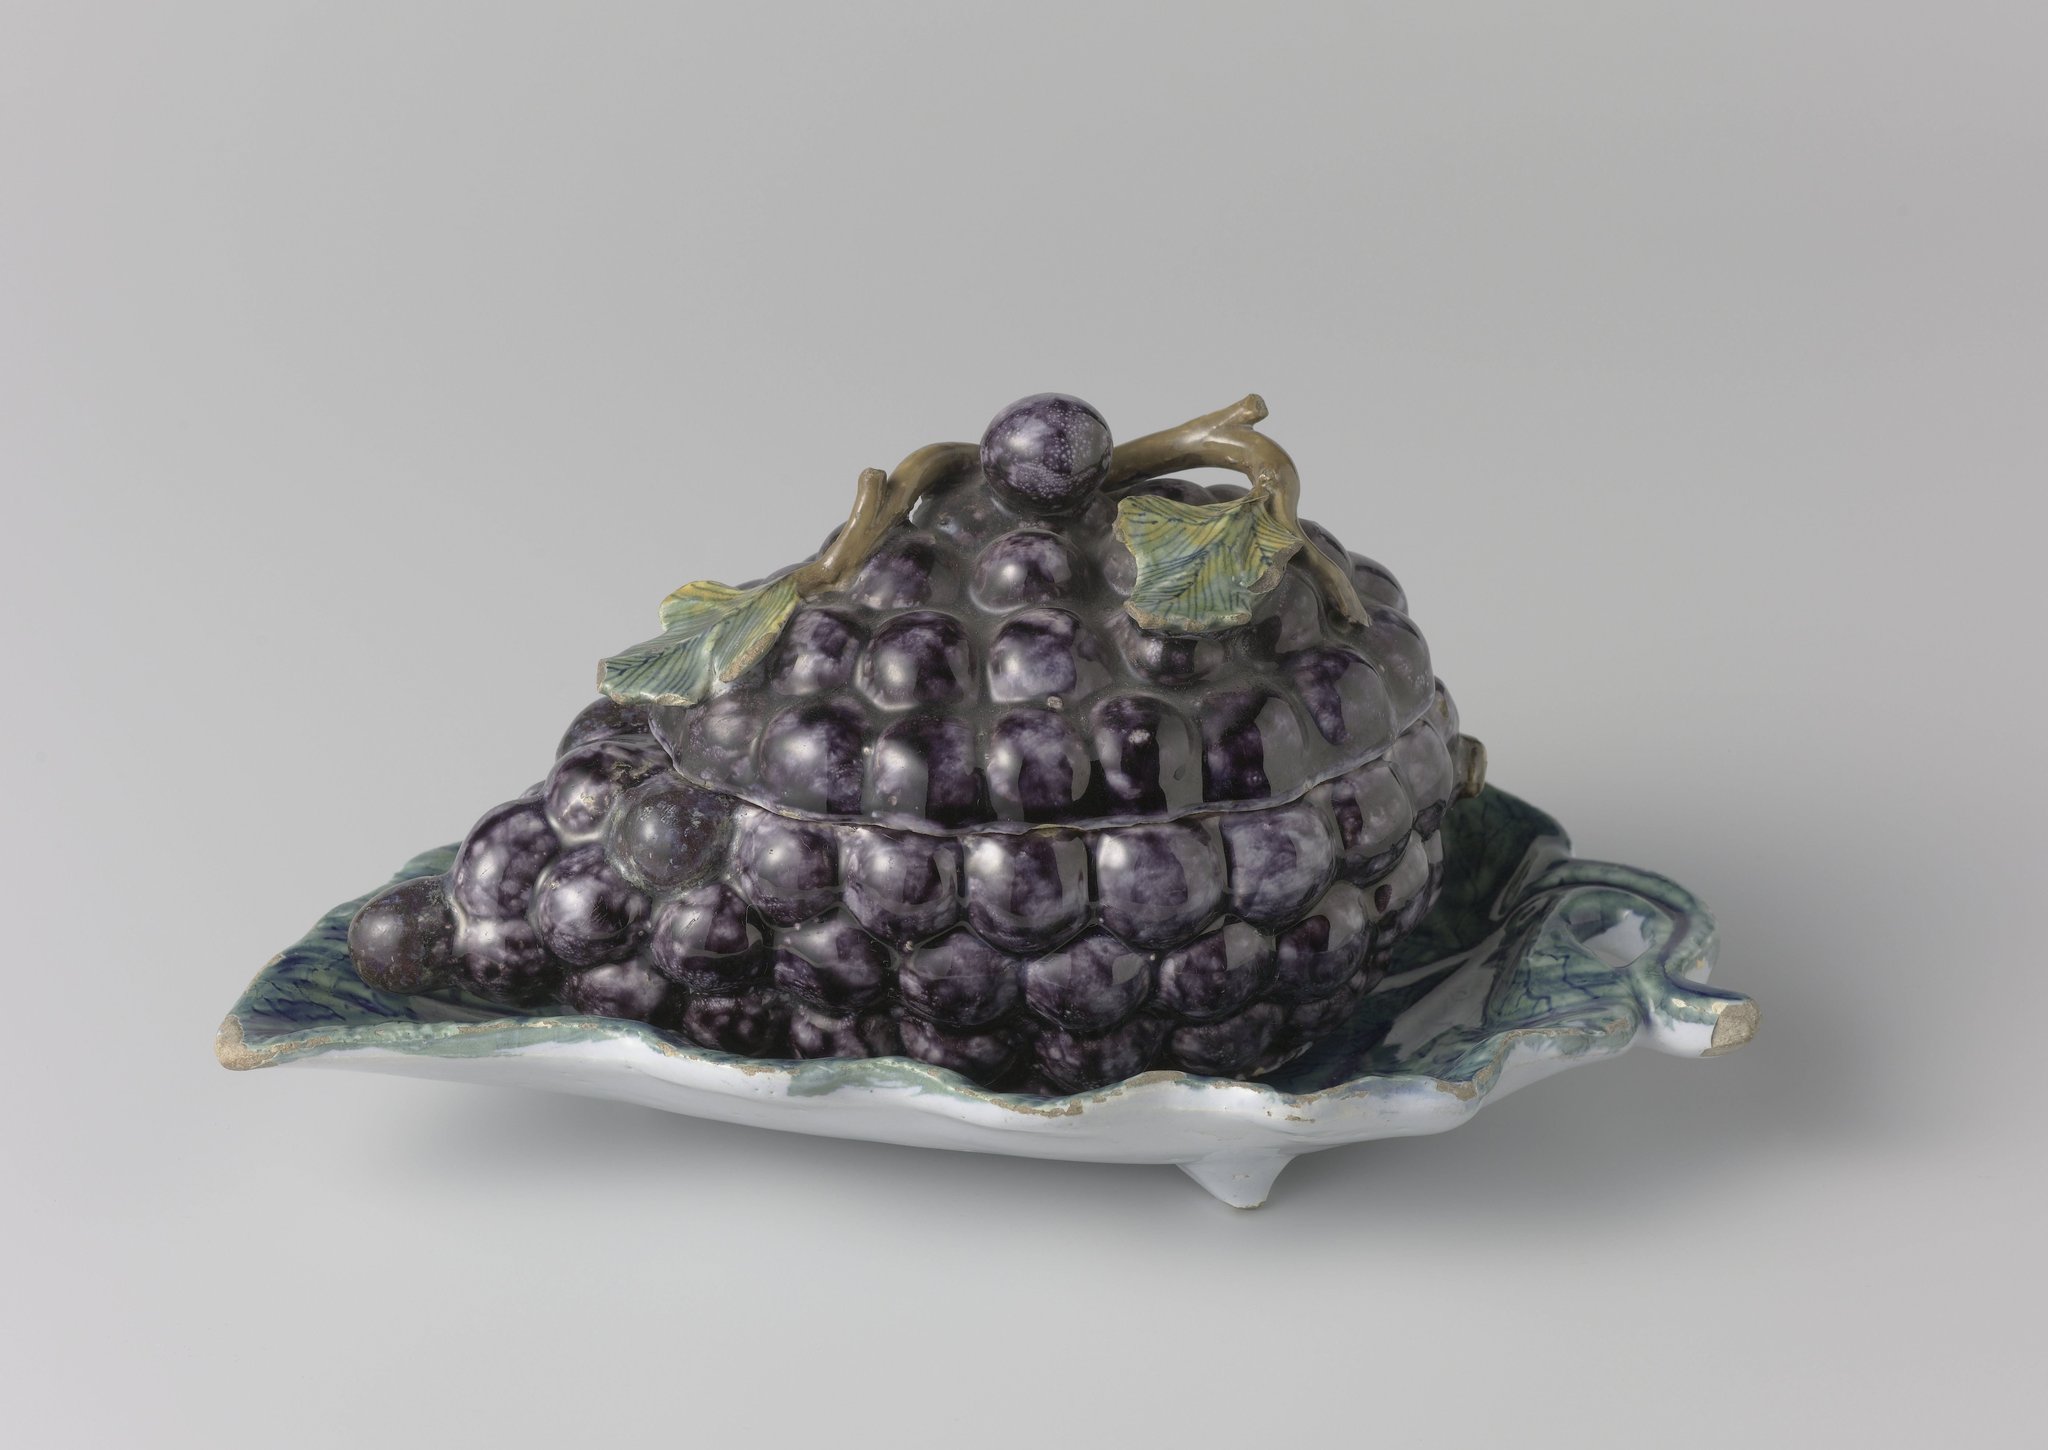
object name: platter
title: Onderschotel van veelkleurig beschilderde faience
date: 1750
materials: faience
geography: delft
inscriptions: mark: ‘figuratief teken bijltje met V’, mark: ‘figuratief teken bijltje met V’, mark: ‘figuratief teken bloem/ 3/ 8’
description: Onderschotel in de vorm van een blad. Horend bij een terrine van aardewerk in de vorm van een druiventros.